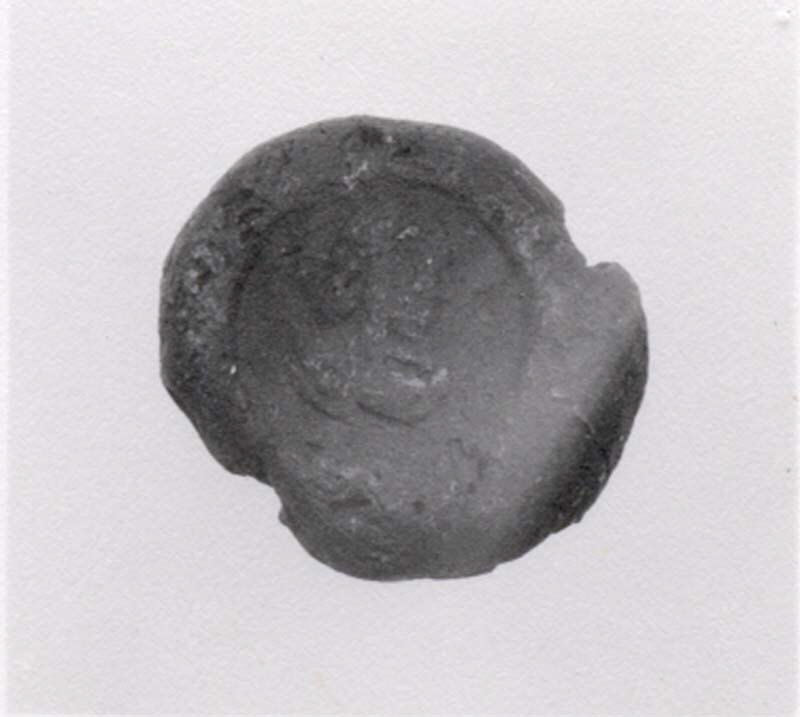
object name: sealing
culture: sasanian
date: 601-700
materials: clay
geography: iran